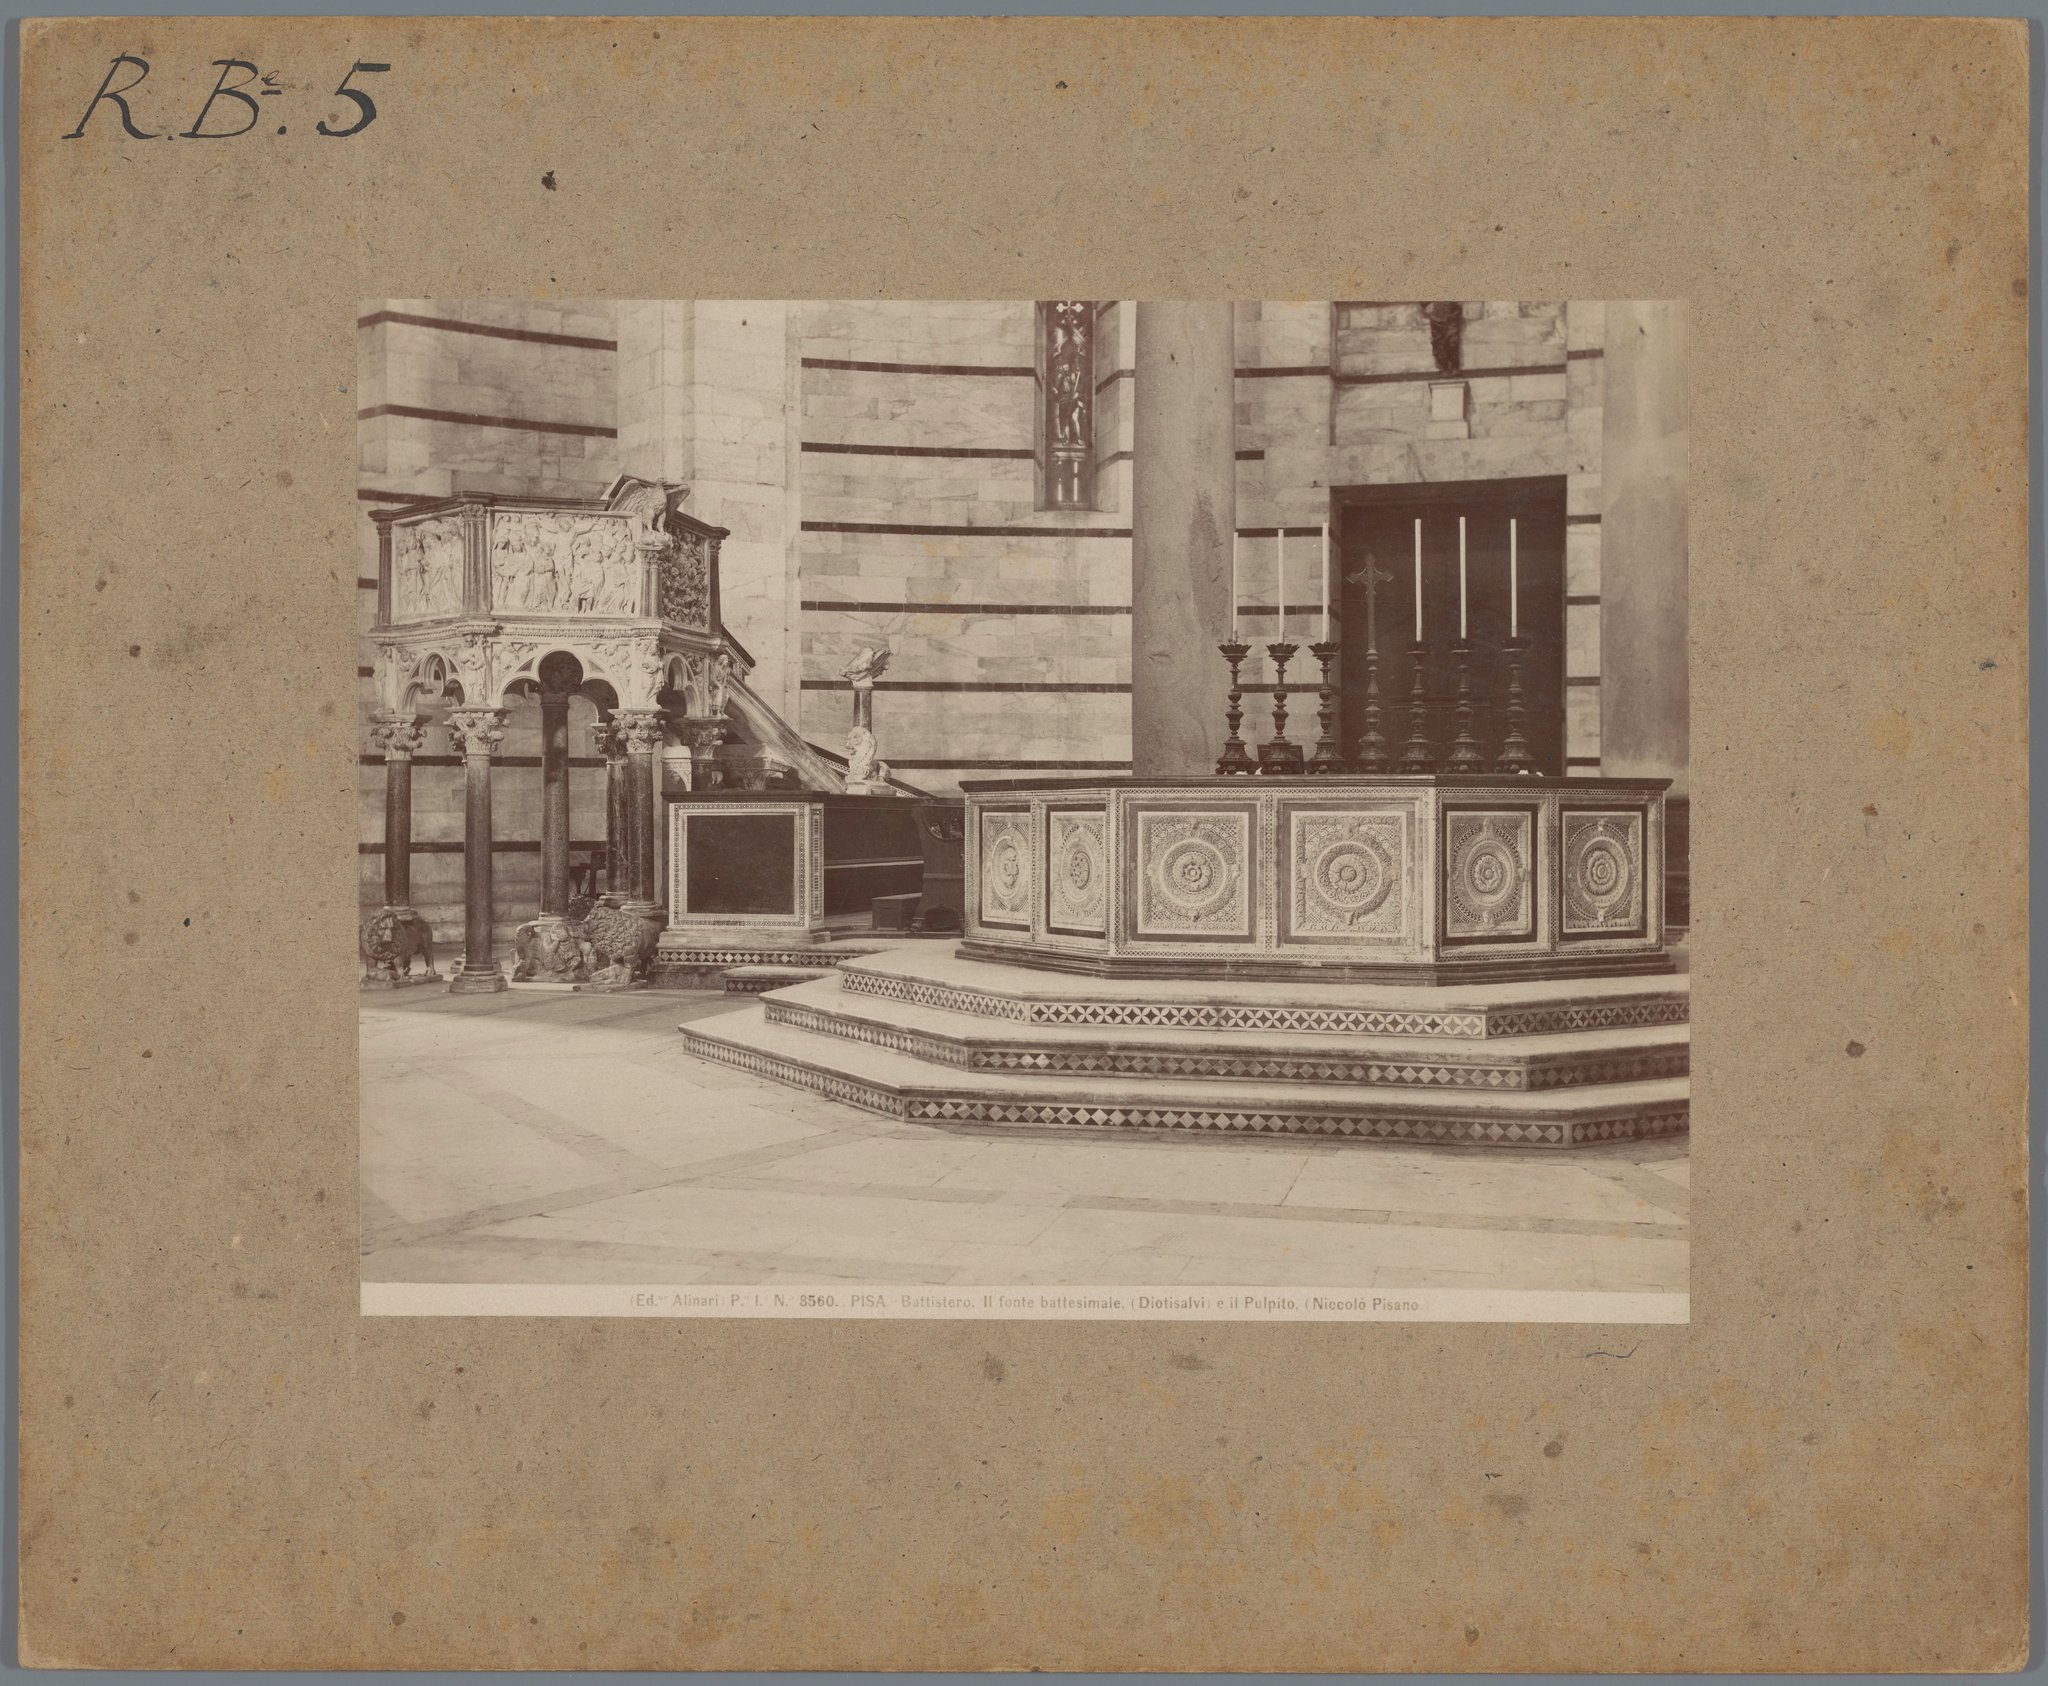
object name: photograph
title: PISA - Battistero. Il fonte battesimale, (Diotisalvi) e il Pulpito, (Niccolò Pisano)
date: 1875-1900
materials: cardboard, photographic support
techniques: albumen print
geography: pisa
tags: pulpit, ambo, chancel, baptismal font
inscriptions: inscription: ‘R.B-. 5.’, number: ‘P.e I.a N.o 8560.’, annotation, collector's mark: Lugt 3937